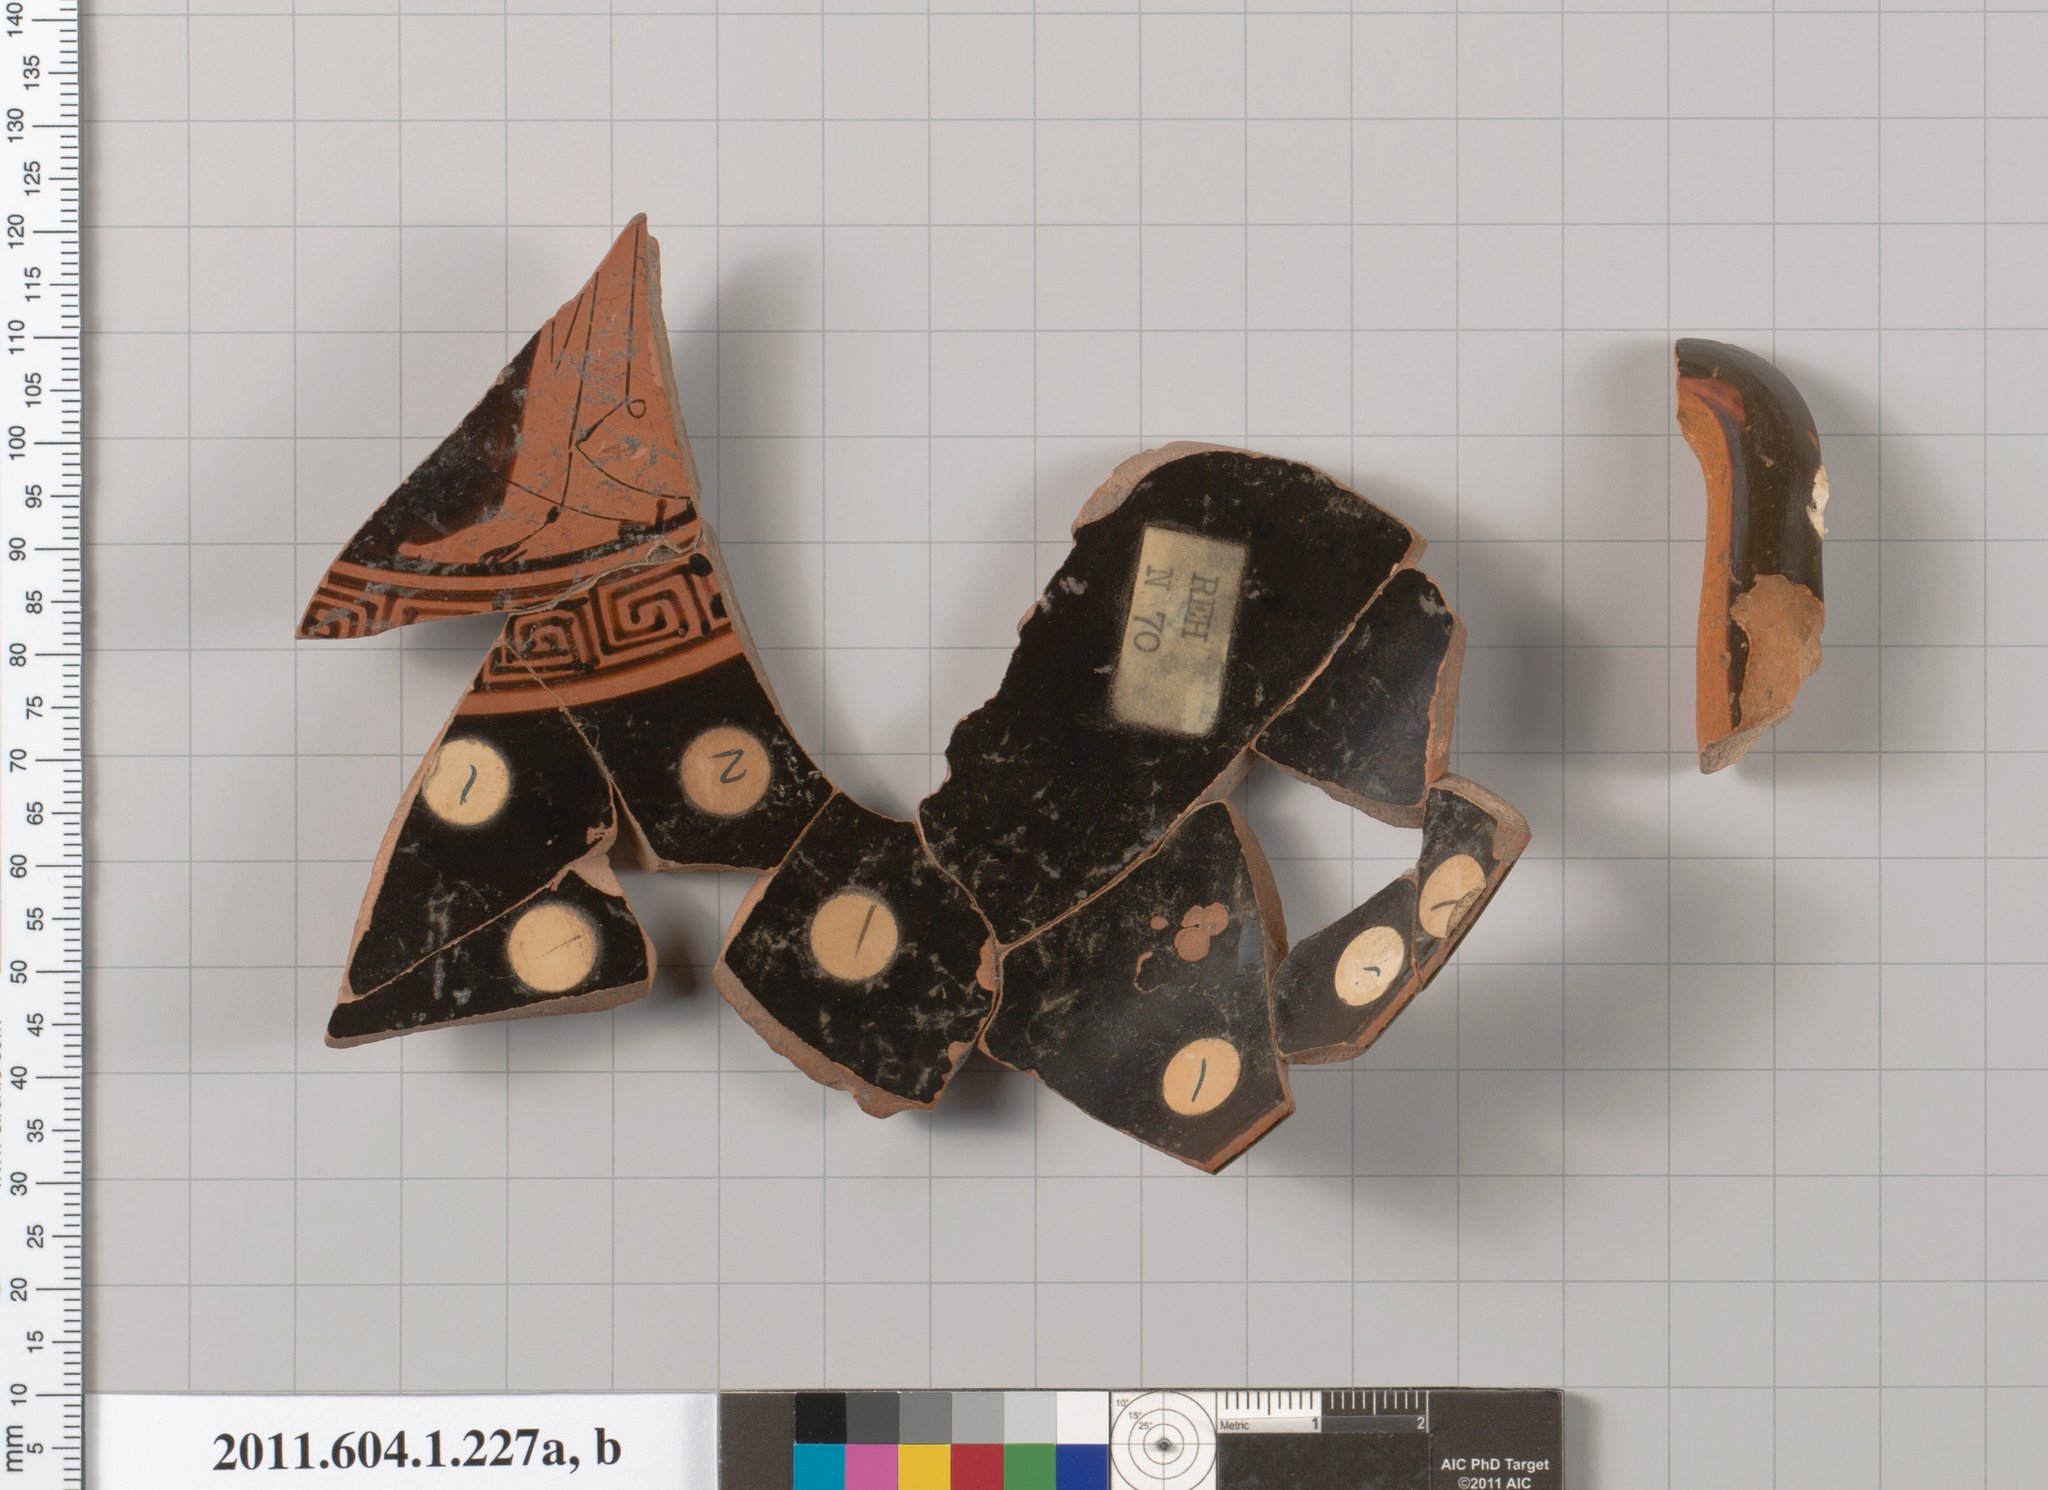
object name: kylix fragment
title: Terracotta fragments of a kylix (drinking cup)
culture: greek, attic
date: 475-451 BCE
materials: terracotta